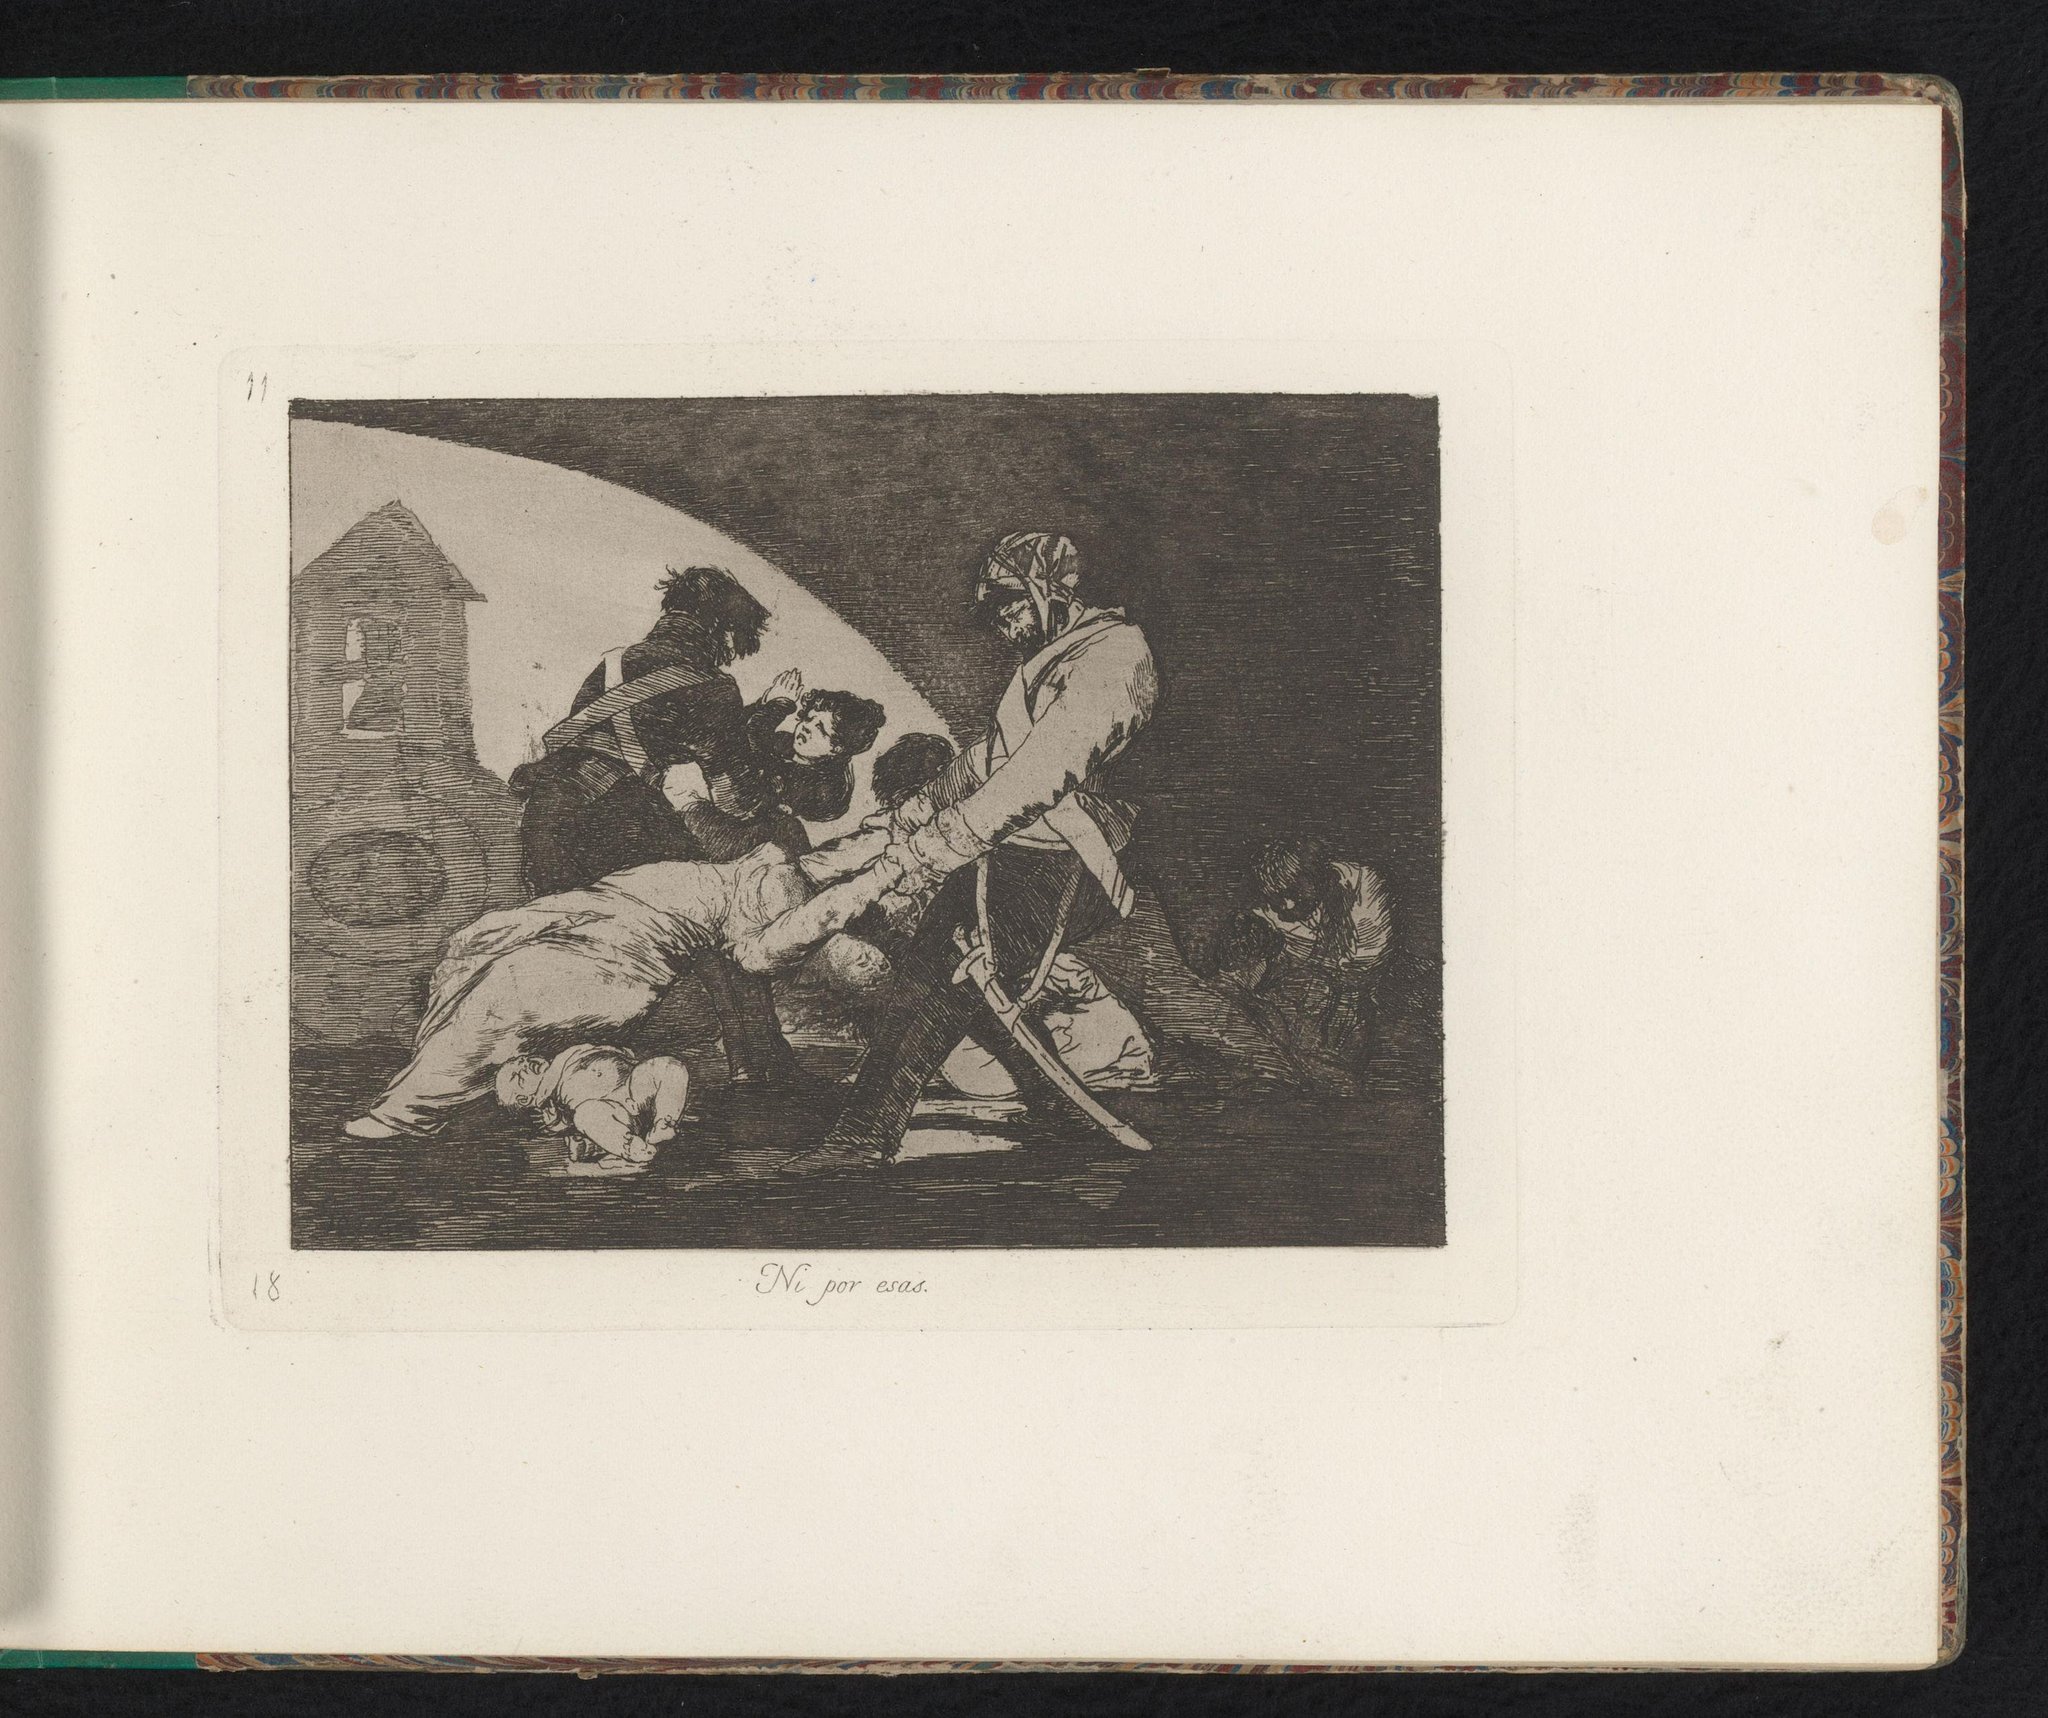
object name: print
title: Ni por esas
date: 1810-1820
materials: paper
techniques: aquatint, drypoint, etching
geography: madrid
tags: rape, violation, soldiers and civilians, horrors of war, spain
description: Deze prent maakt deel uit van een album.